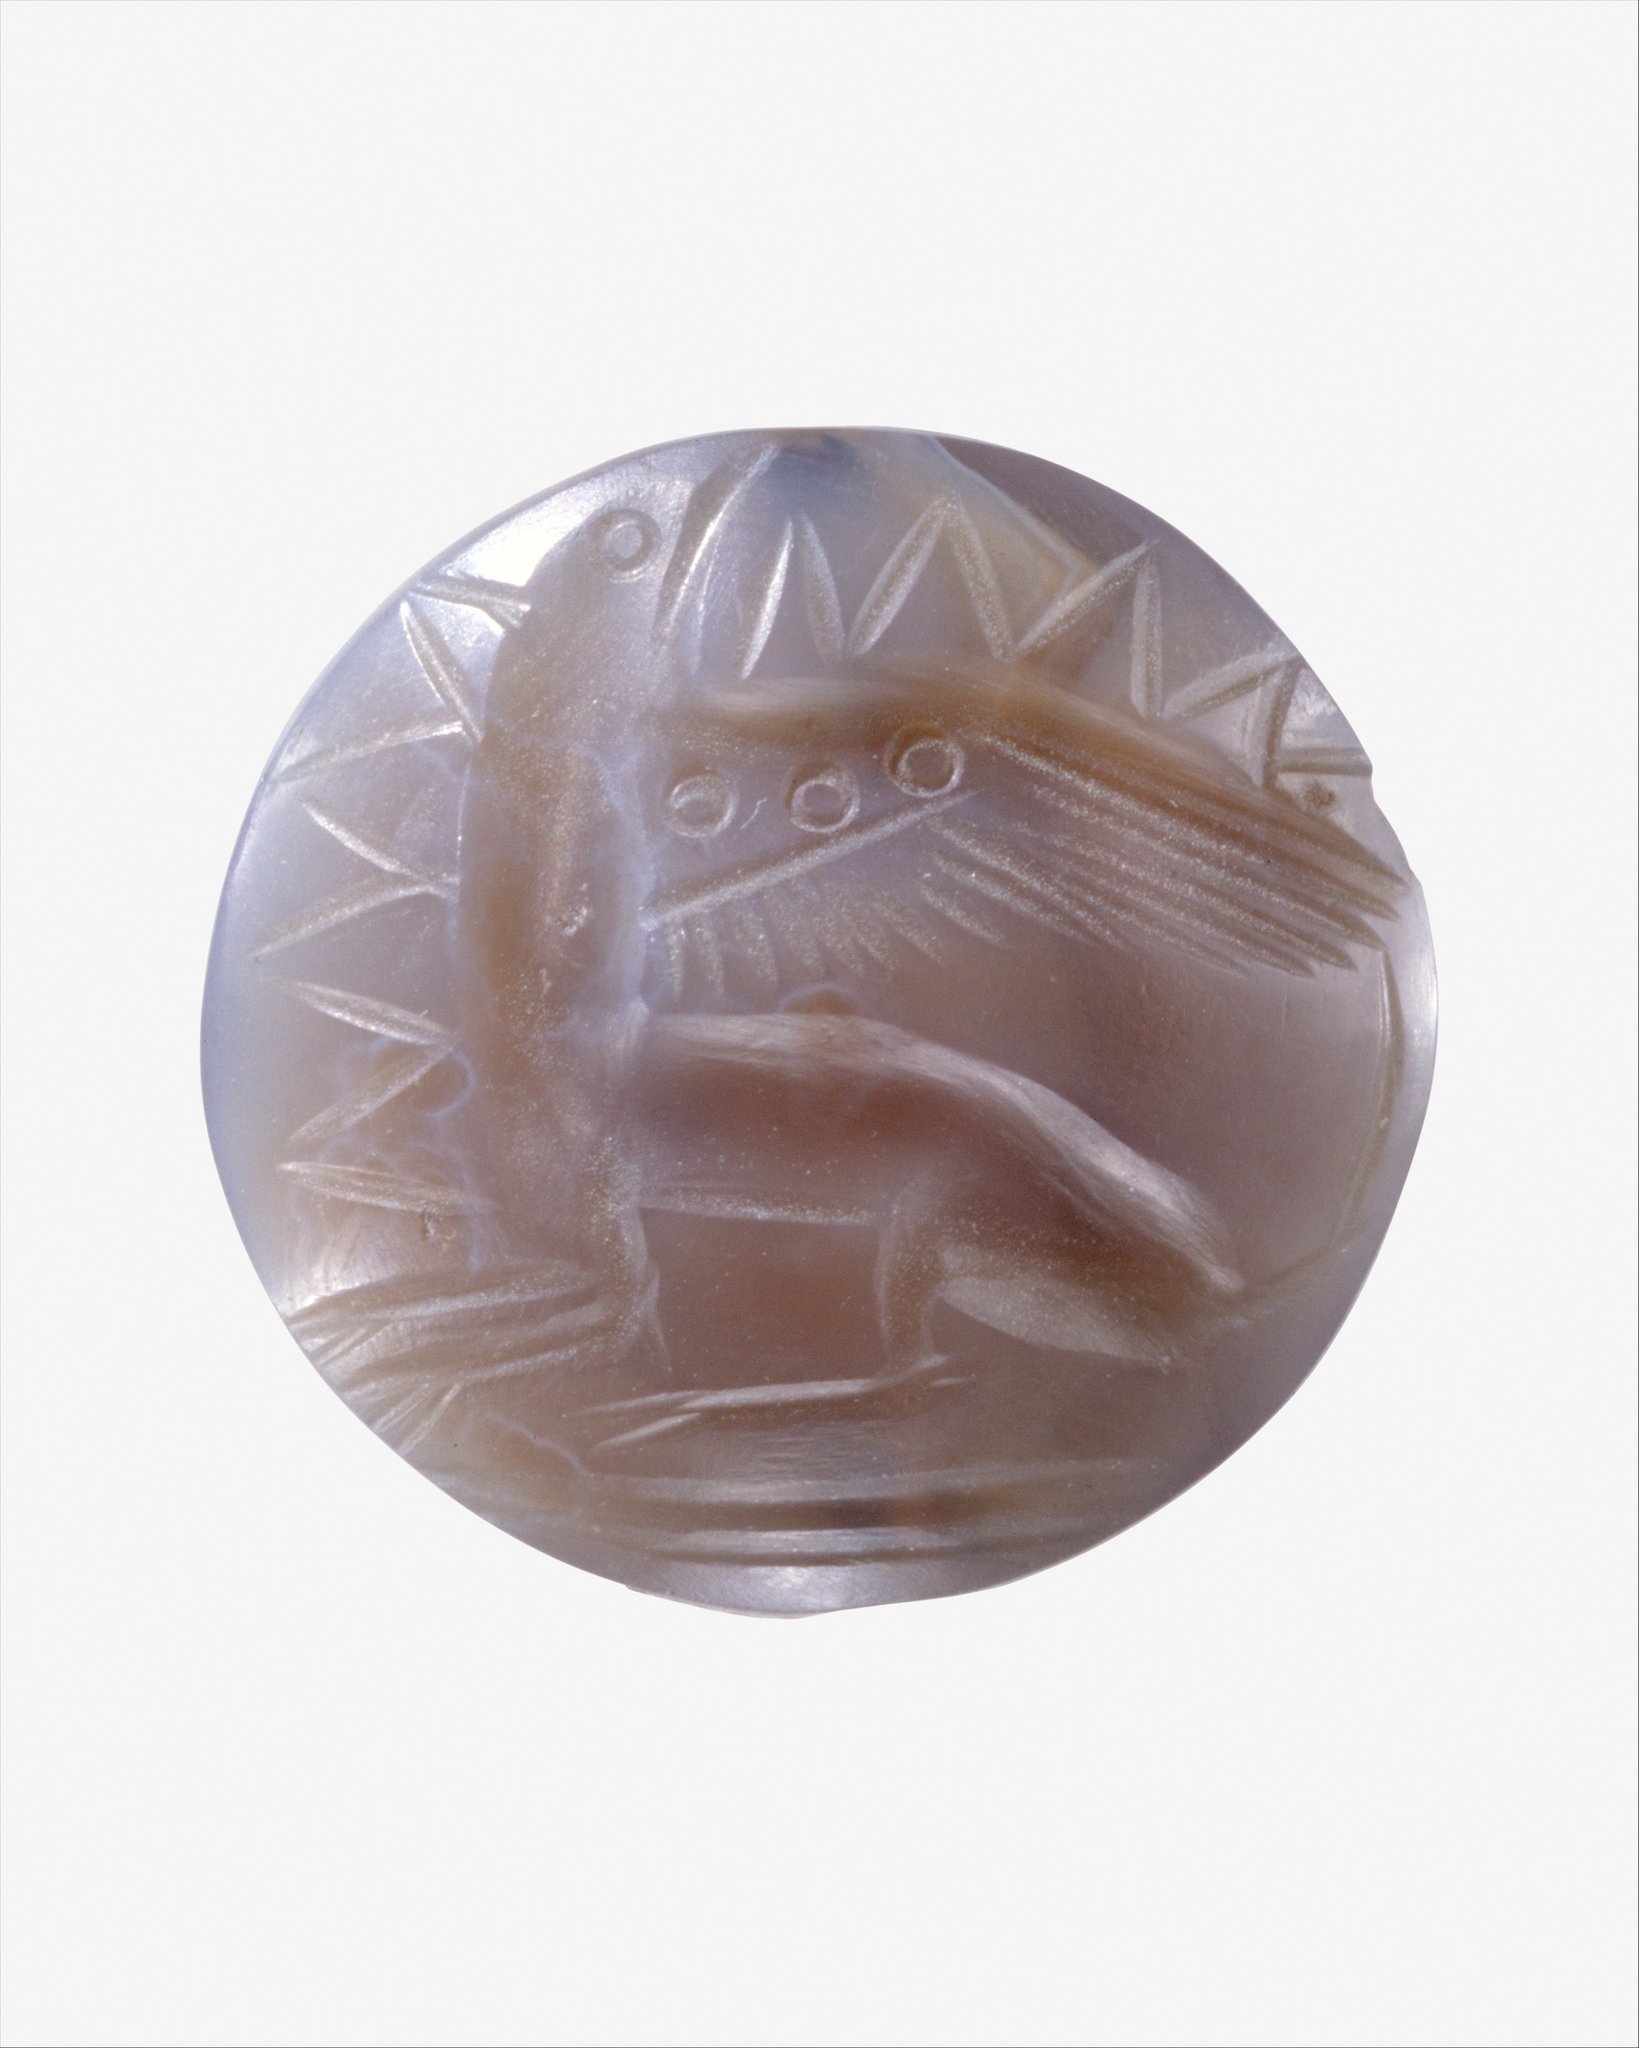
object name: seal, lentoid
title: Agate Lentoid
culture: minoan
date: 1450-1400 BCE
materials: stone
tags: griffins